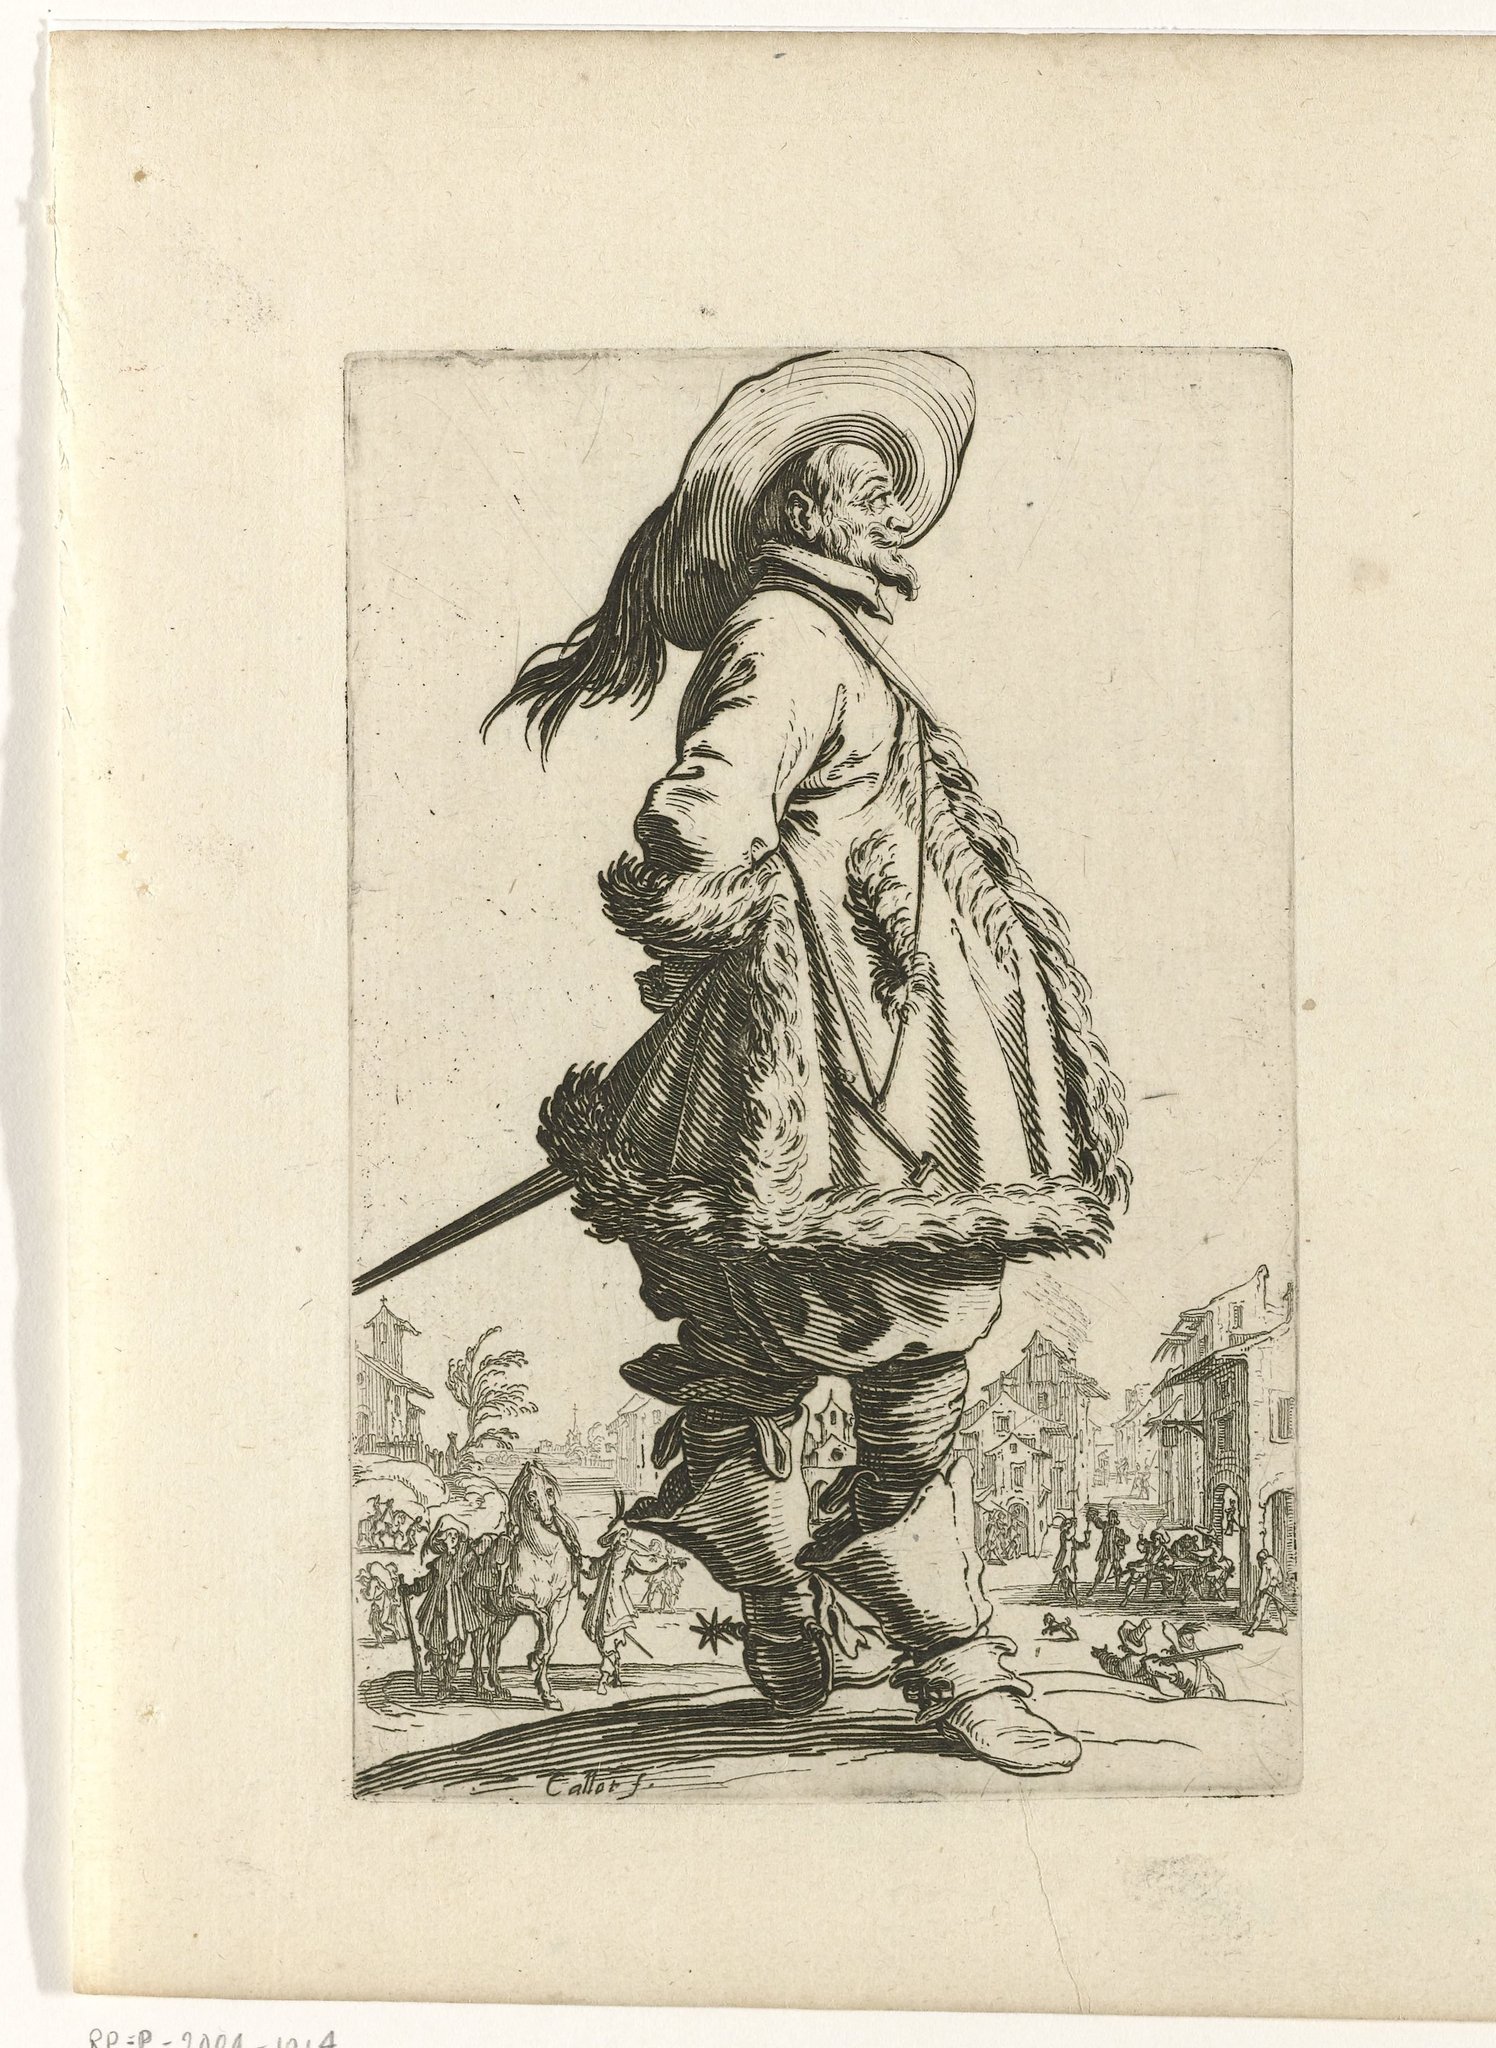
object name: costume print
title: La Noblesse de Lorraine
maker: jacques callot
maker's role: draughtsman, print maker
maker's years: 1592-1635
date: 1624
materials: paper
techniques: etching